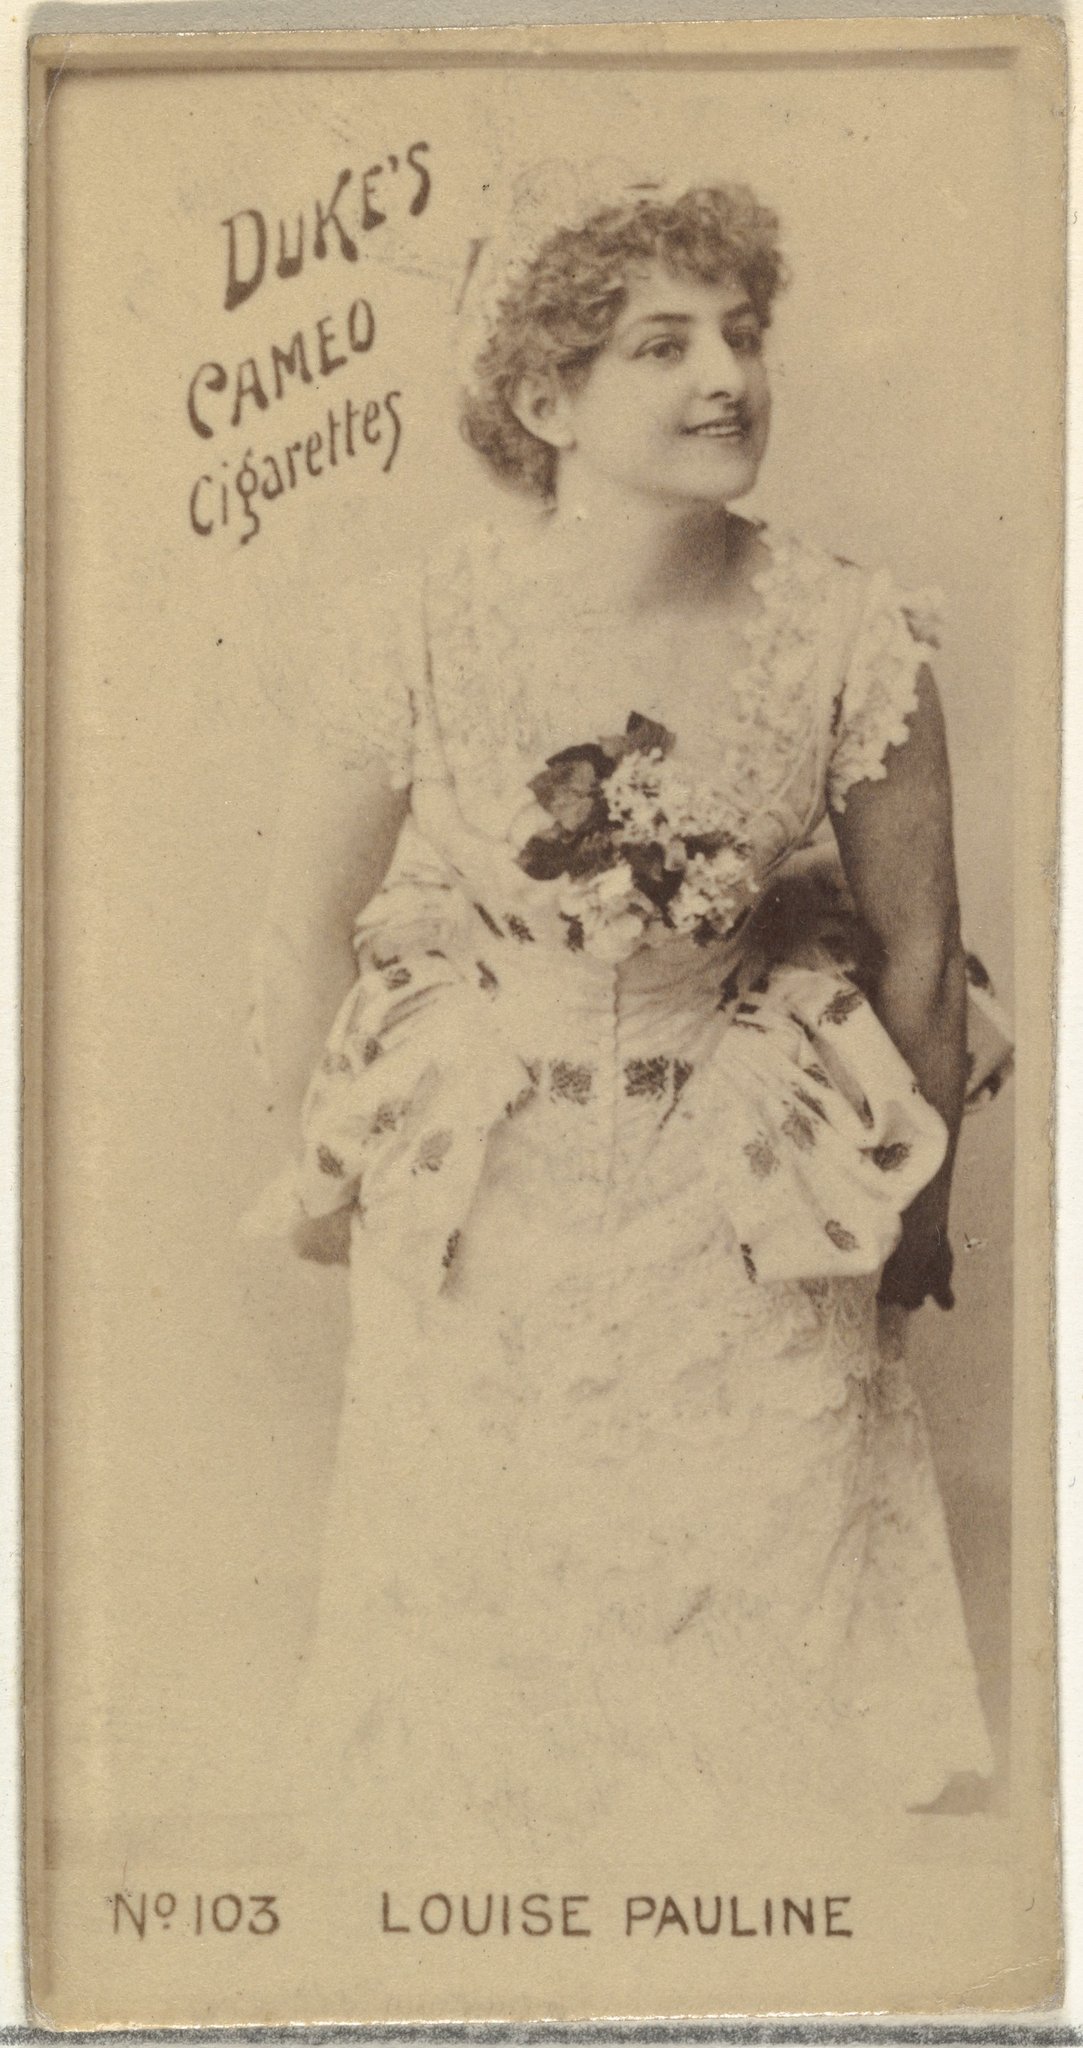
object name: photograph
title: Card Number 103, Louise Pauline, from the Actors and Actresses series (N145-4) issued by Duke Sons & Co. to promote Cameo Cigarettes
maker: w. duke, sons & co.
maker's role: publisher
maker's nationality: american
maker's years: 1870-1920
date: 1880-1889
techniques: albumen silver print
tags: portraits,women,actresses